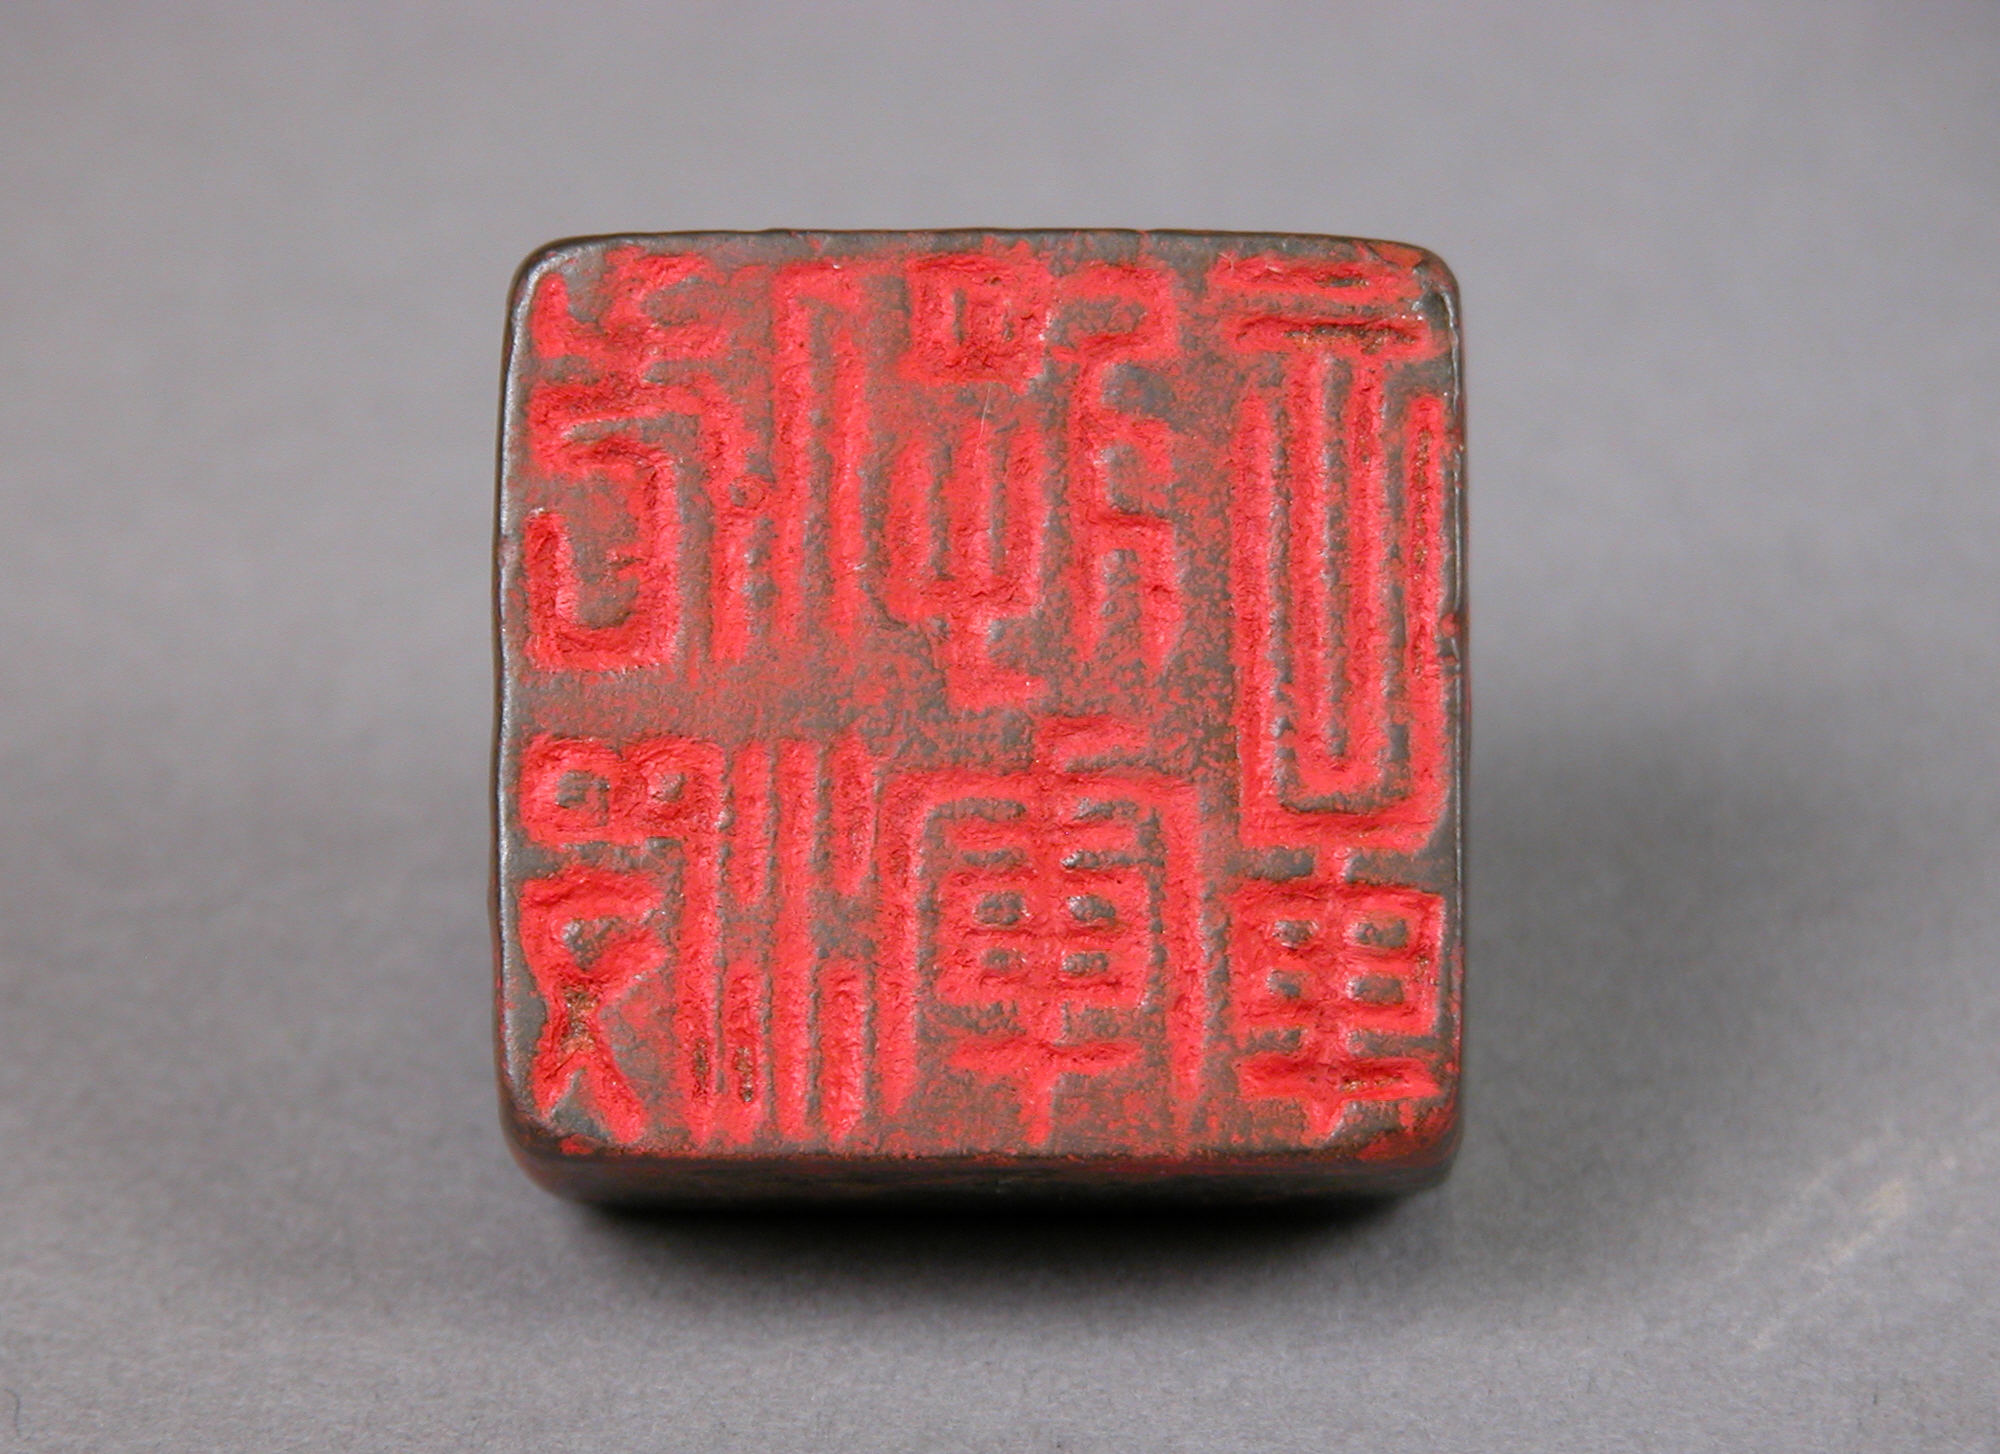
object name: seal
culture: chinese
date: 1368-1644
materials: bronze